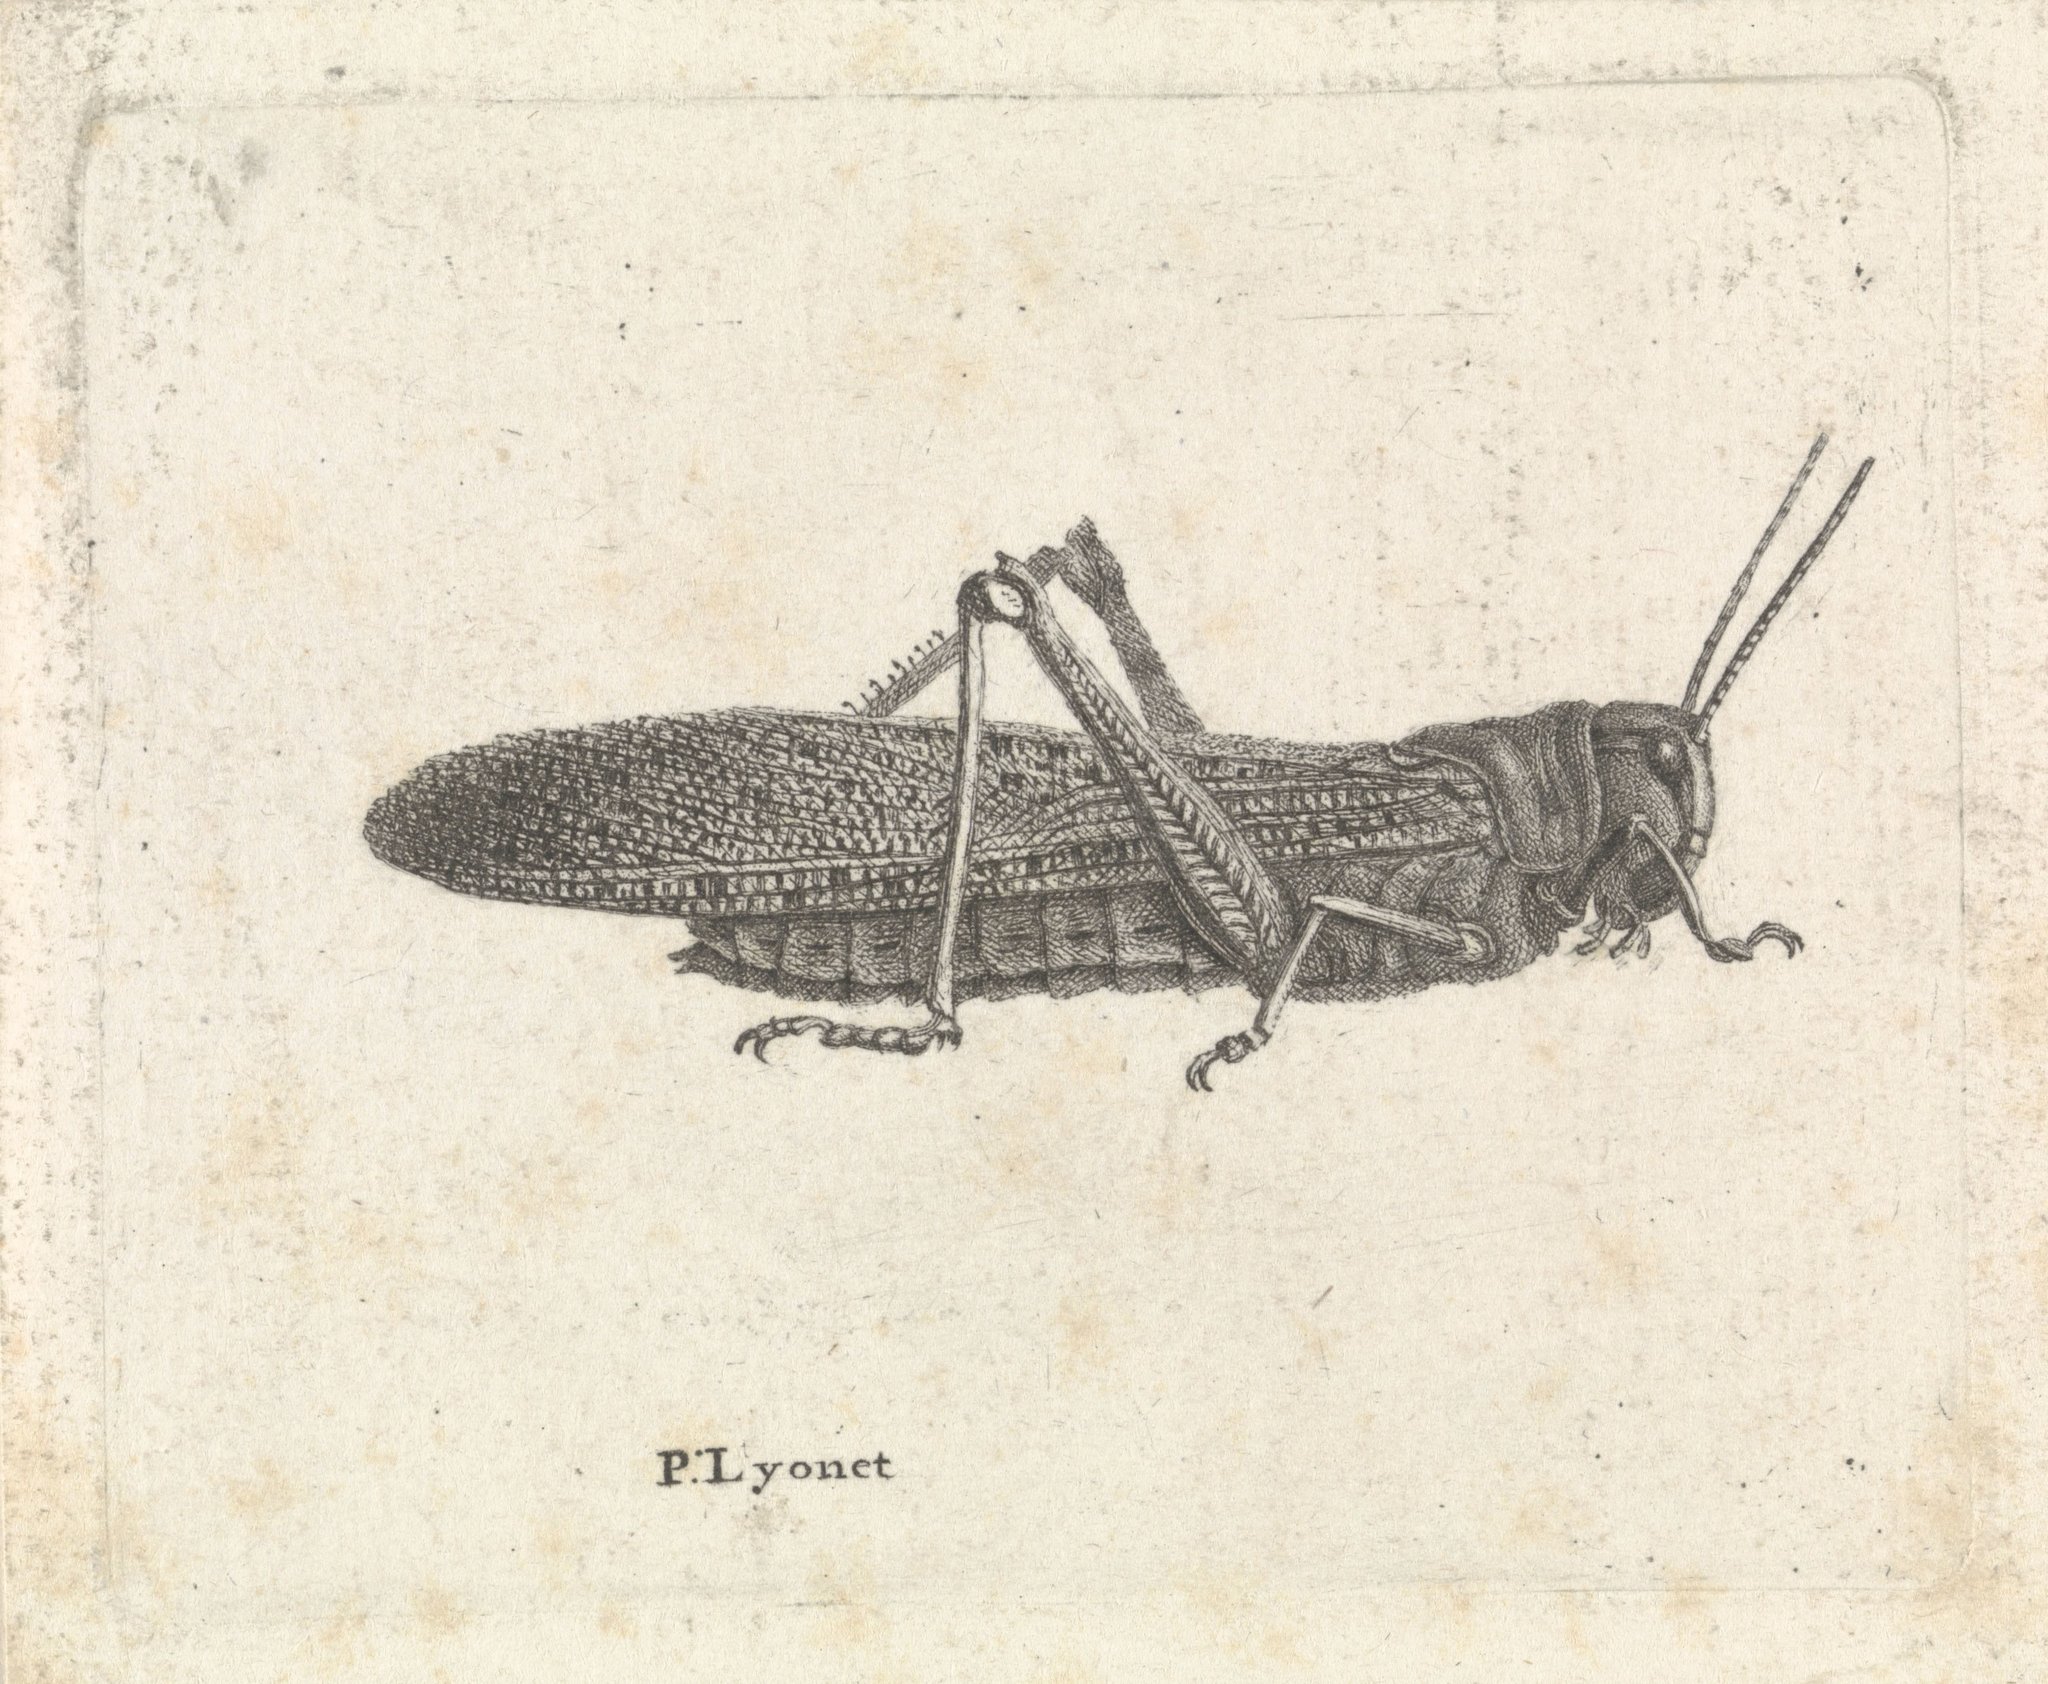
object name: print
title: Sprinkhaan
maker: pieter lyonet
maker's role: draughtsman, print maker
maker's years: 1706-1789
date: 1716-1789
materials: paper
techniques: etching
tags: insects: grass-hopper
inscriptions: collector's mark: Lugt 2228